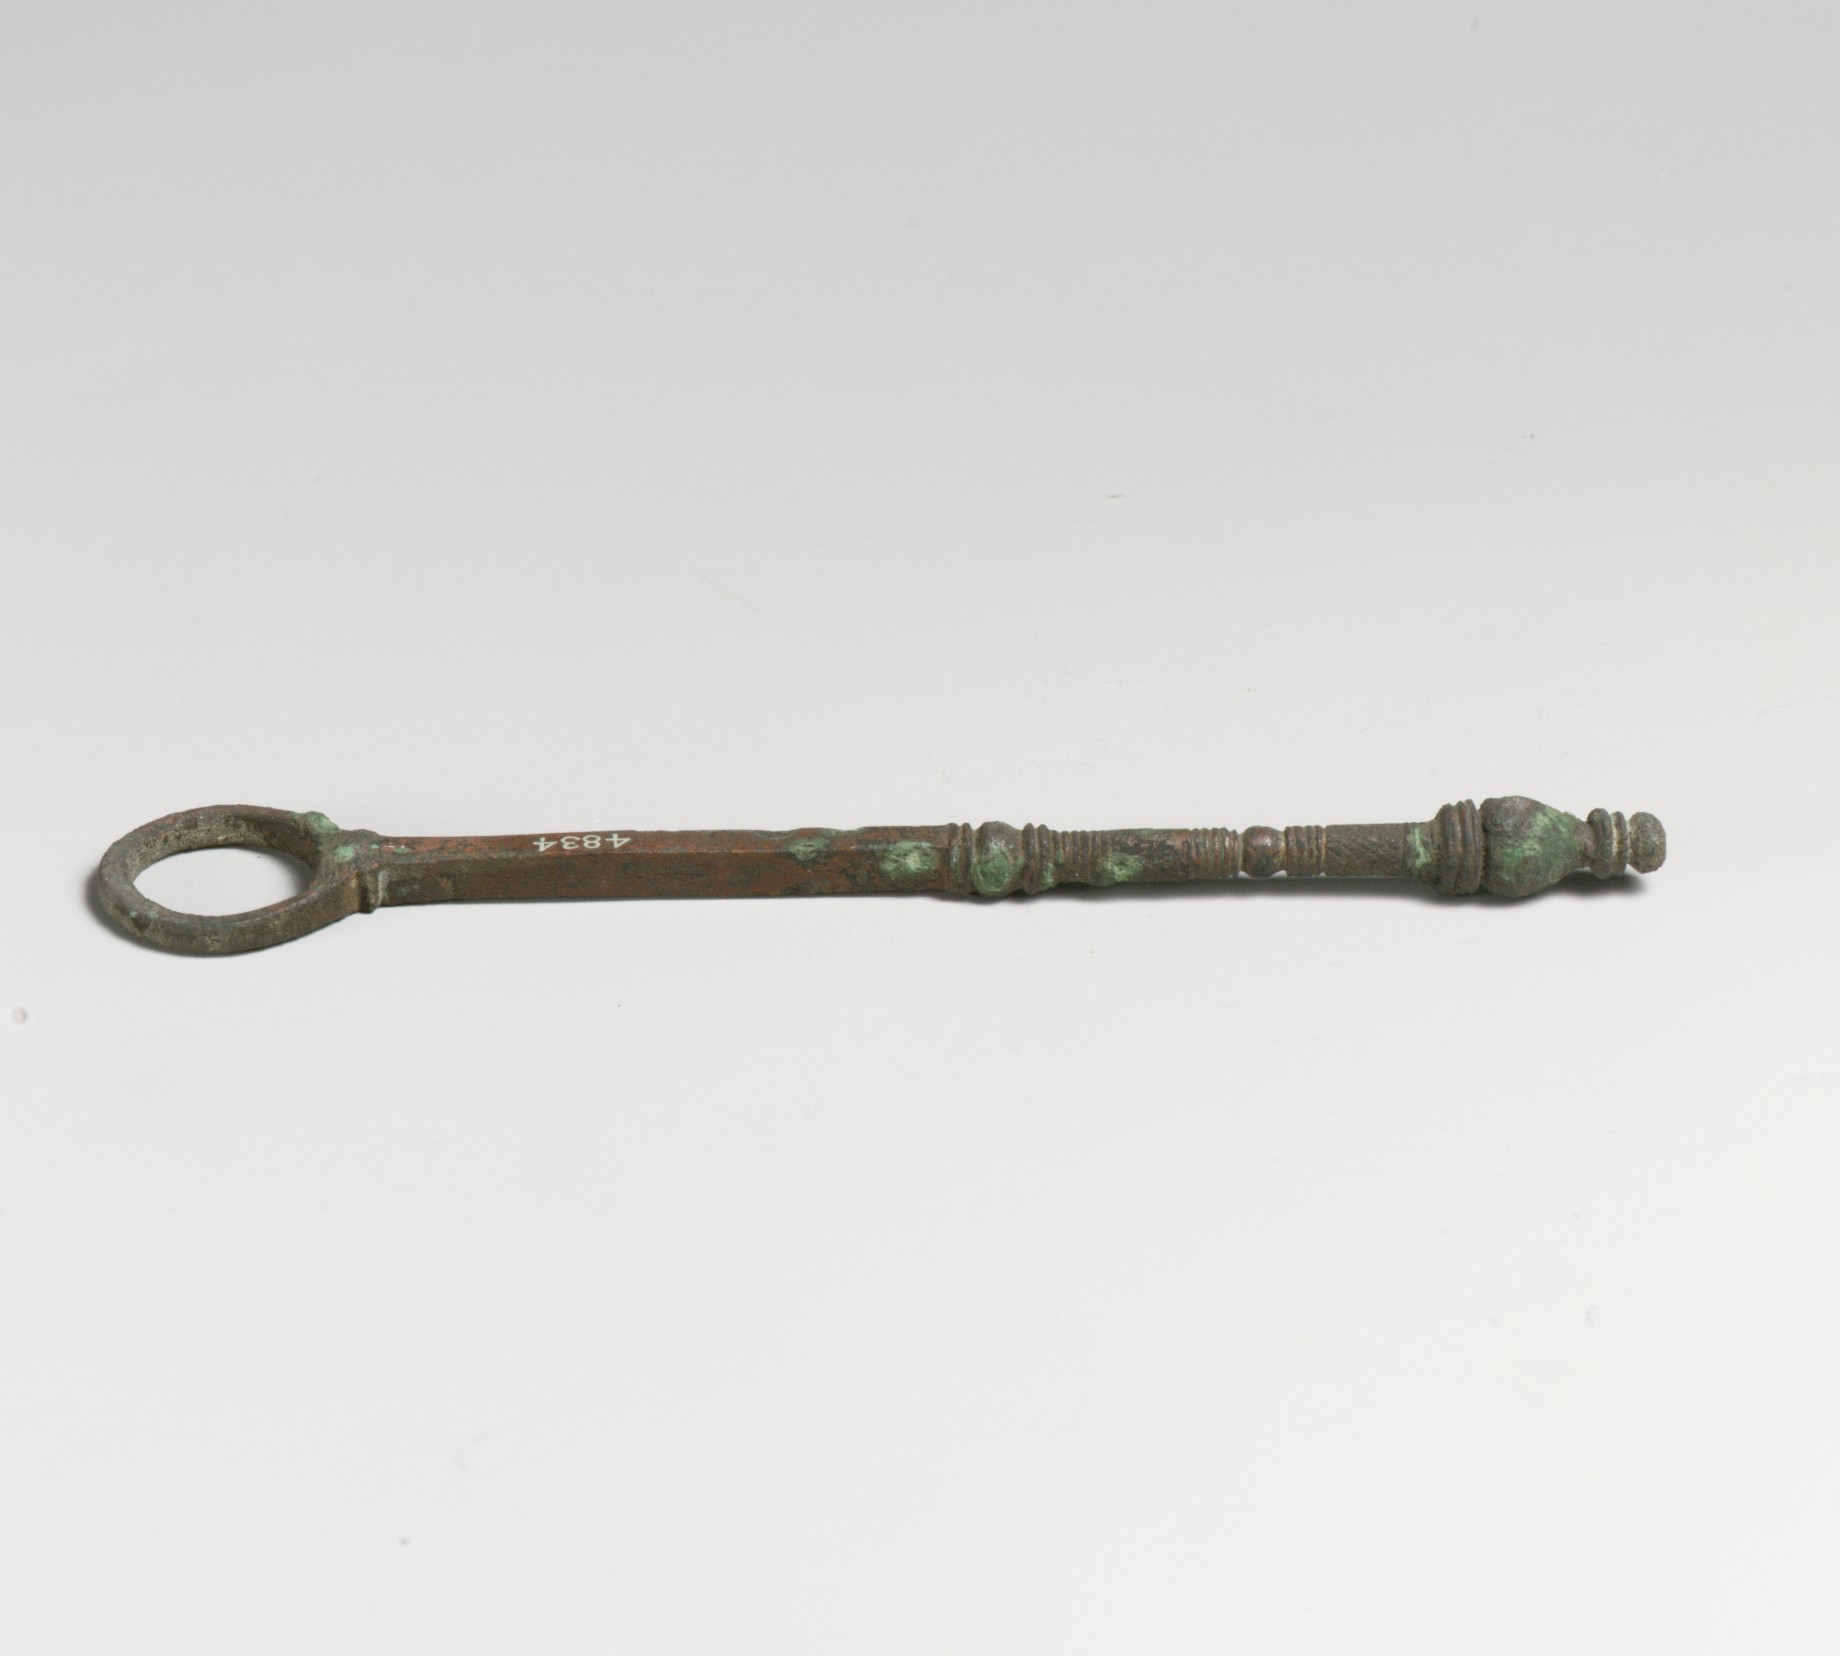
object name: rod, dipping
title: Bronze distaff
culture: roman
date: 1-100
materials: bronze